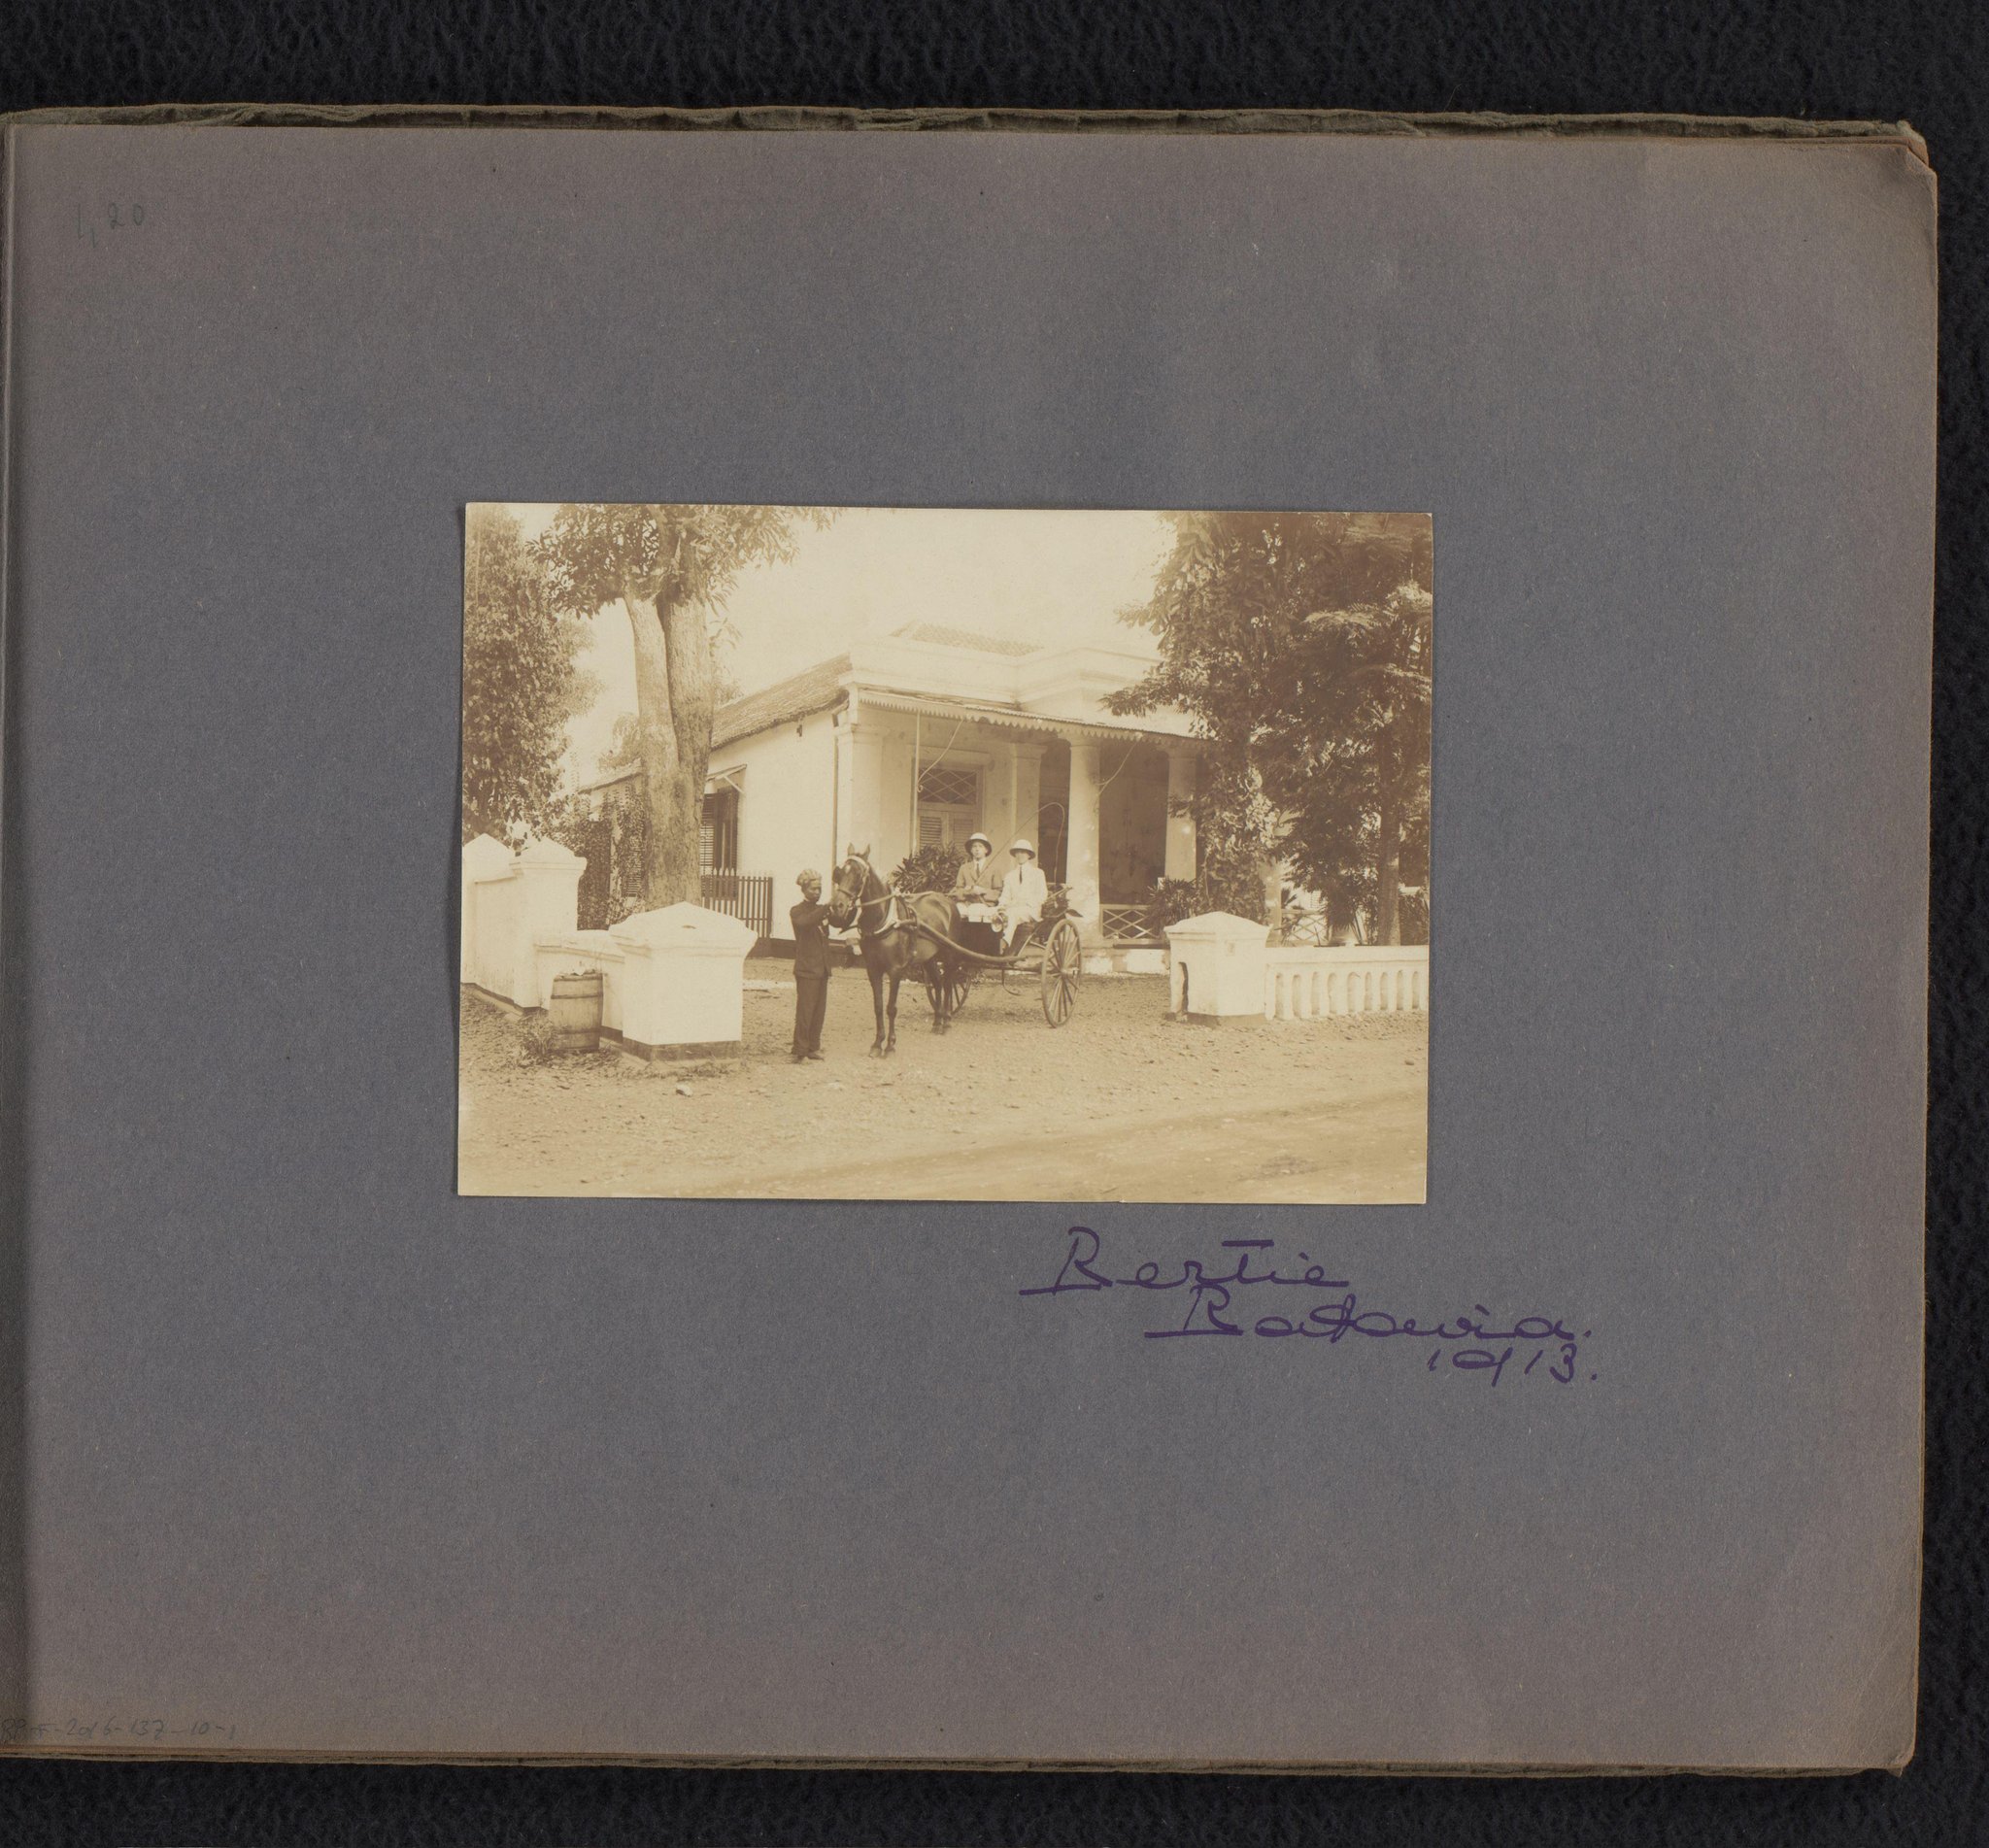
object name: album leaf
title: Twee mannen in een paardenkoets, ernaast een bediende, in Batavia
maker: Anonymous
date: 1913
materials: paper, cardboard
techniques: gelatin silver print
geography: batavia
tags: two-wheeled vehicle drawn by one animal, batavia